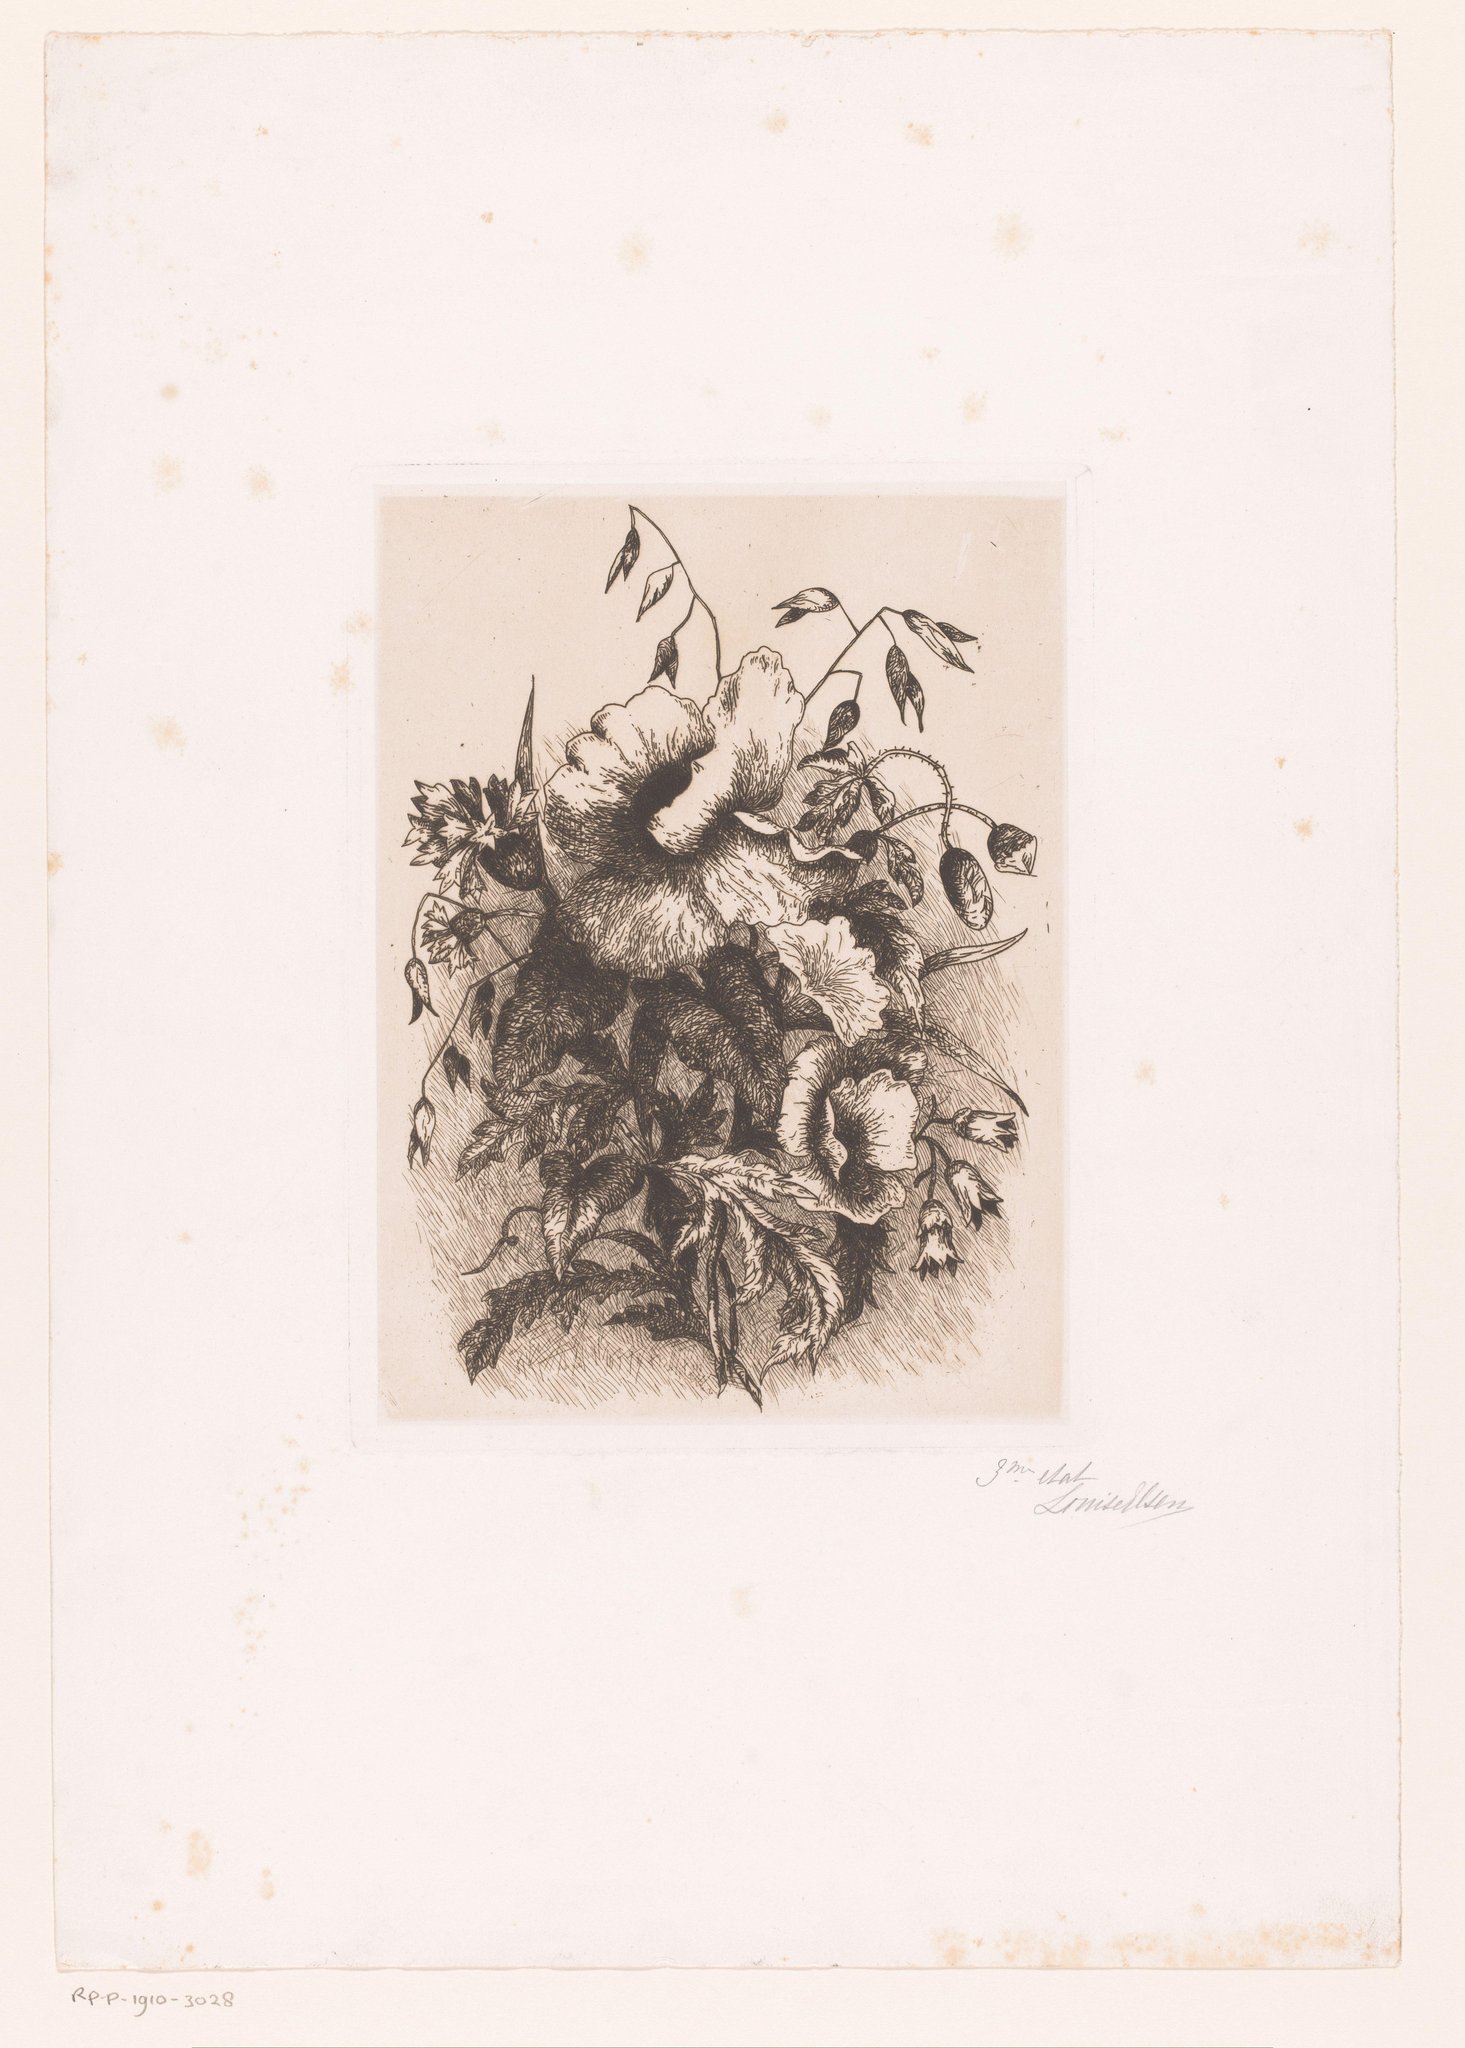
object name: print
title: Bloemstilleven met klaprozen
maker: louise elsen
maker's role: print maker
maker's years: 1853-1937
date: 1860-1888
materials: paper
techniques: etching, intaglio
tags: flowers: cornflower, still life of plants, flowers and fruit, flowers: poppy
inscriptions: inscription: ‘3me etat’, collector's mark: Lugt 2228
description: Onder andere drie klaprozen in het midden, twee papaverknoppen rechts, haver en een korenbloem links.